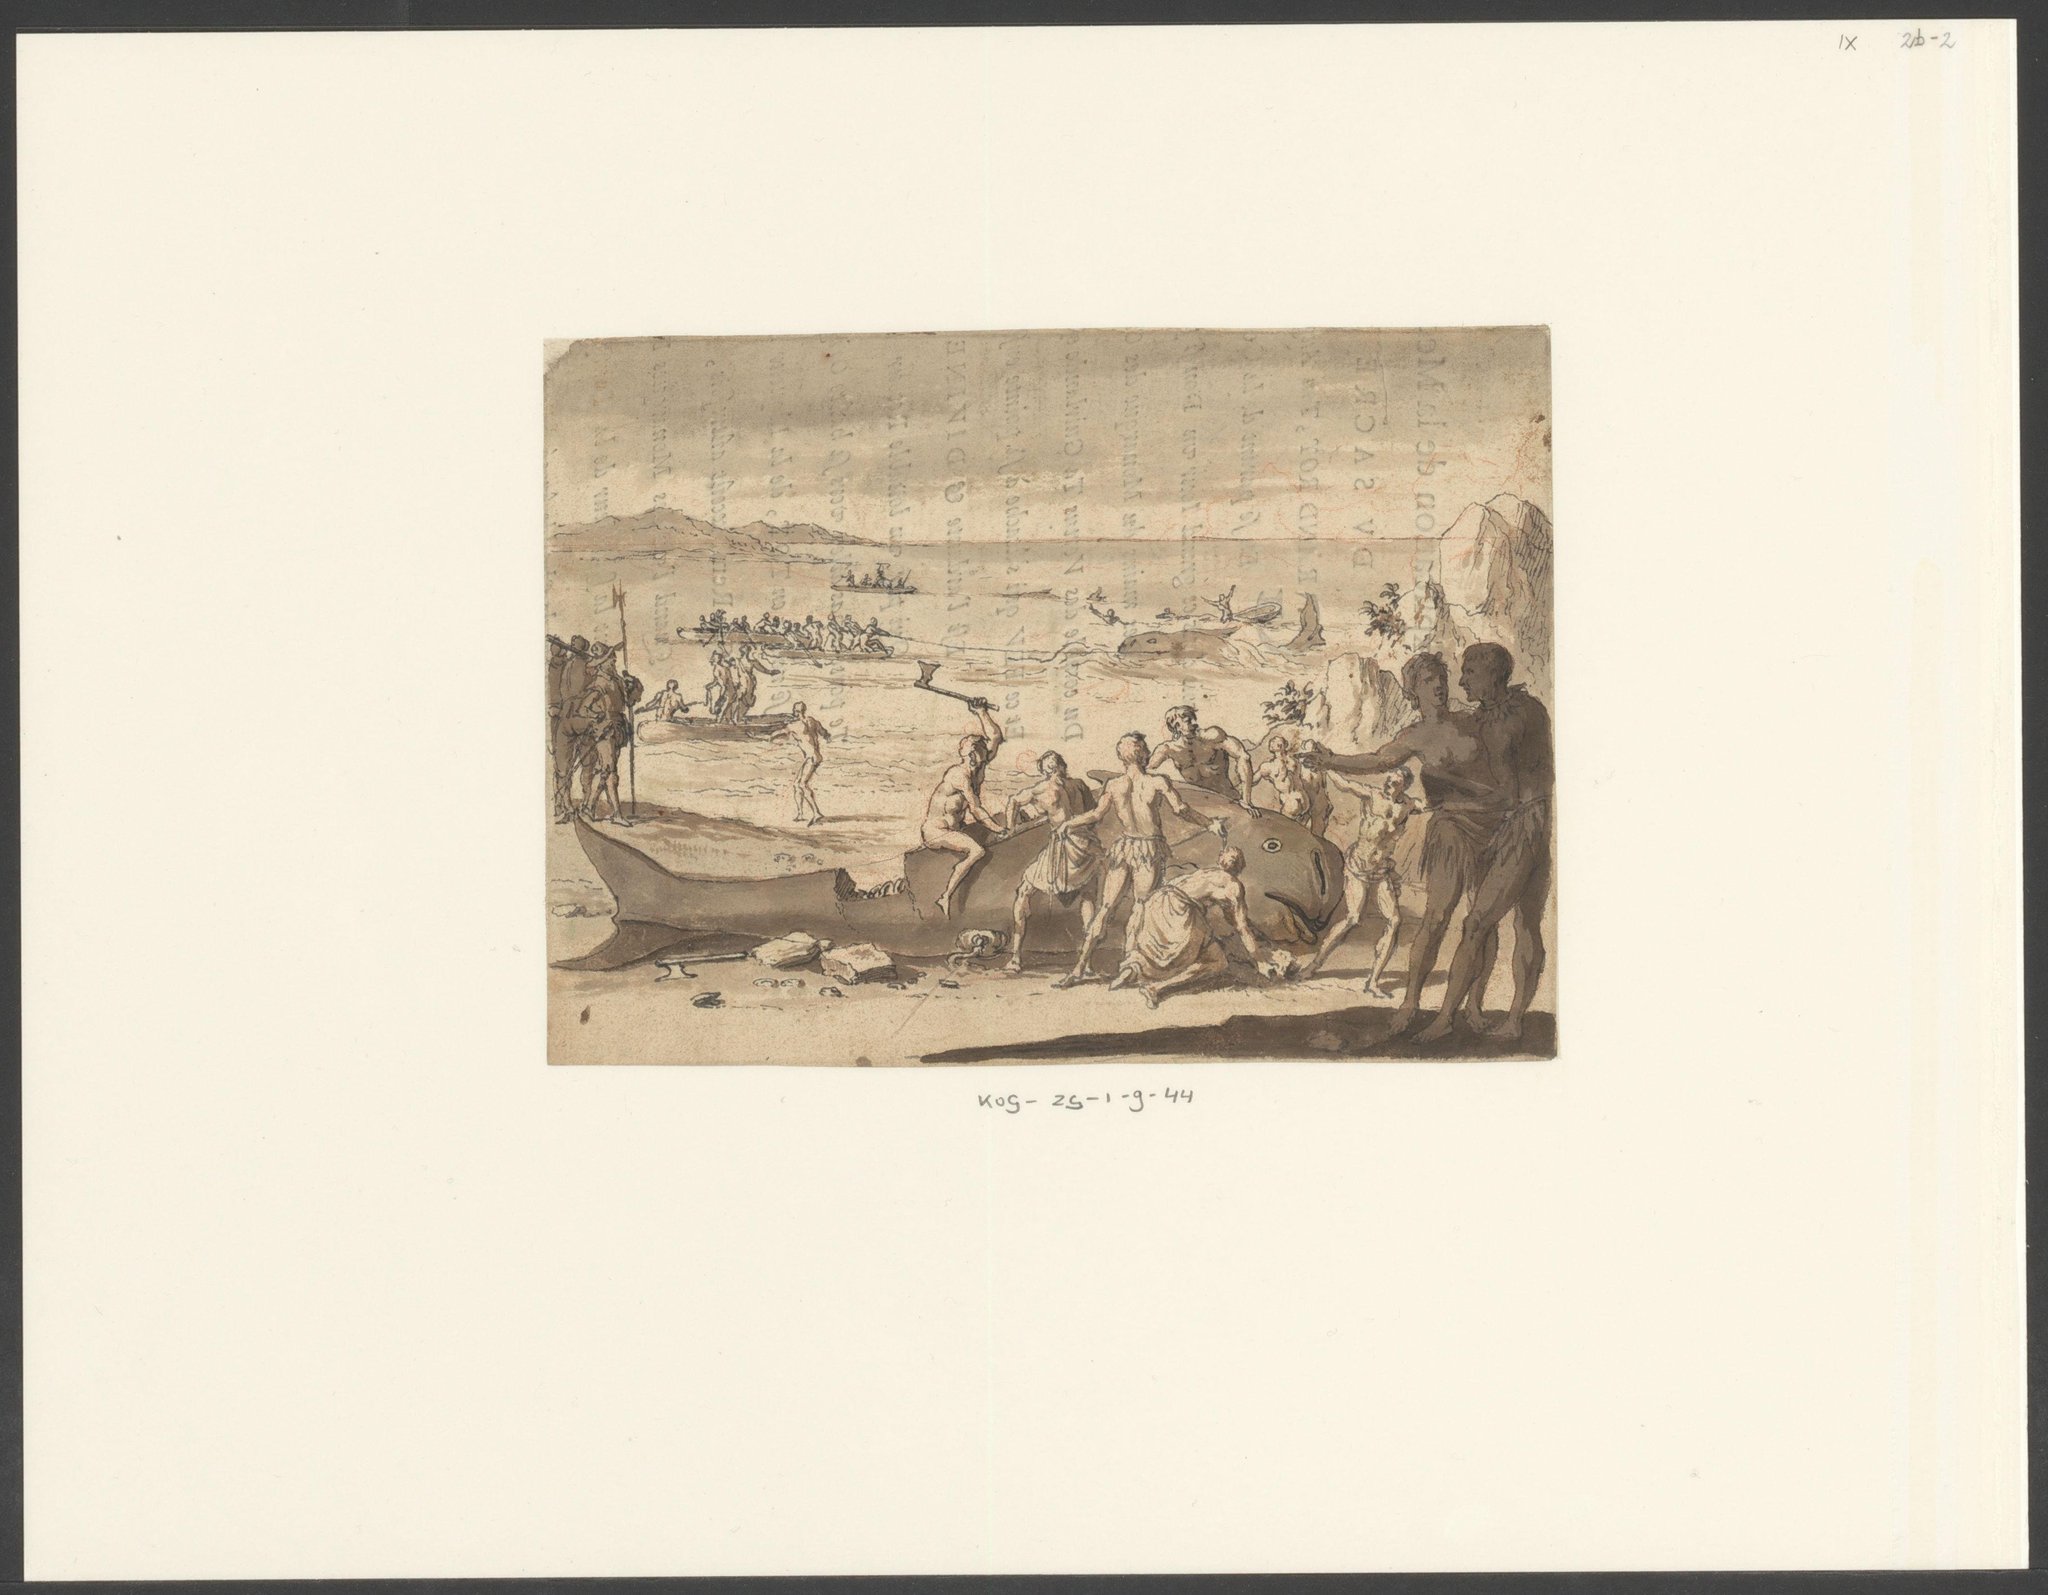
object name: drawing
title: Walvisvangst, mogelijk in Zuid-Amerika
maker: Anonymous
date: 1650-1699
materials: chalk, ink, paper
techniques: brush, letterpress printing, pen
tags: beach, swimming mammals: whale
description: Walvisvangst, op het strand wordt een walvis geslacht. Op zee worden meerdere walvissen vanuit roeiboten gevangen. Onderwerpsrubrieken binnen de Atlas Zeden en Gewoonten: Handel, nijverheid en verkeer, Visscherij, Walvischvangst.